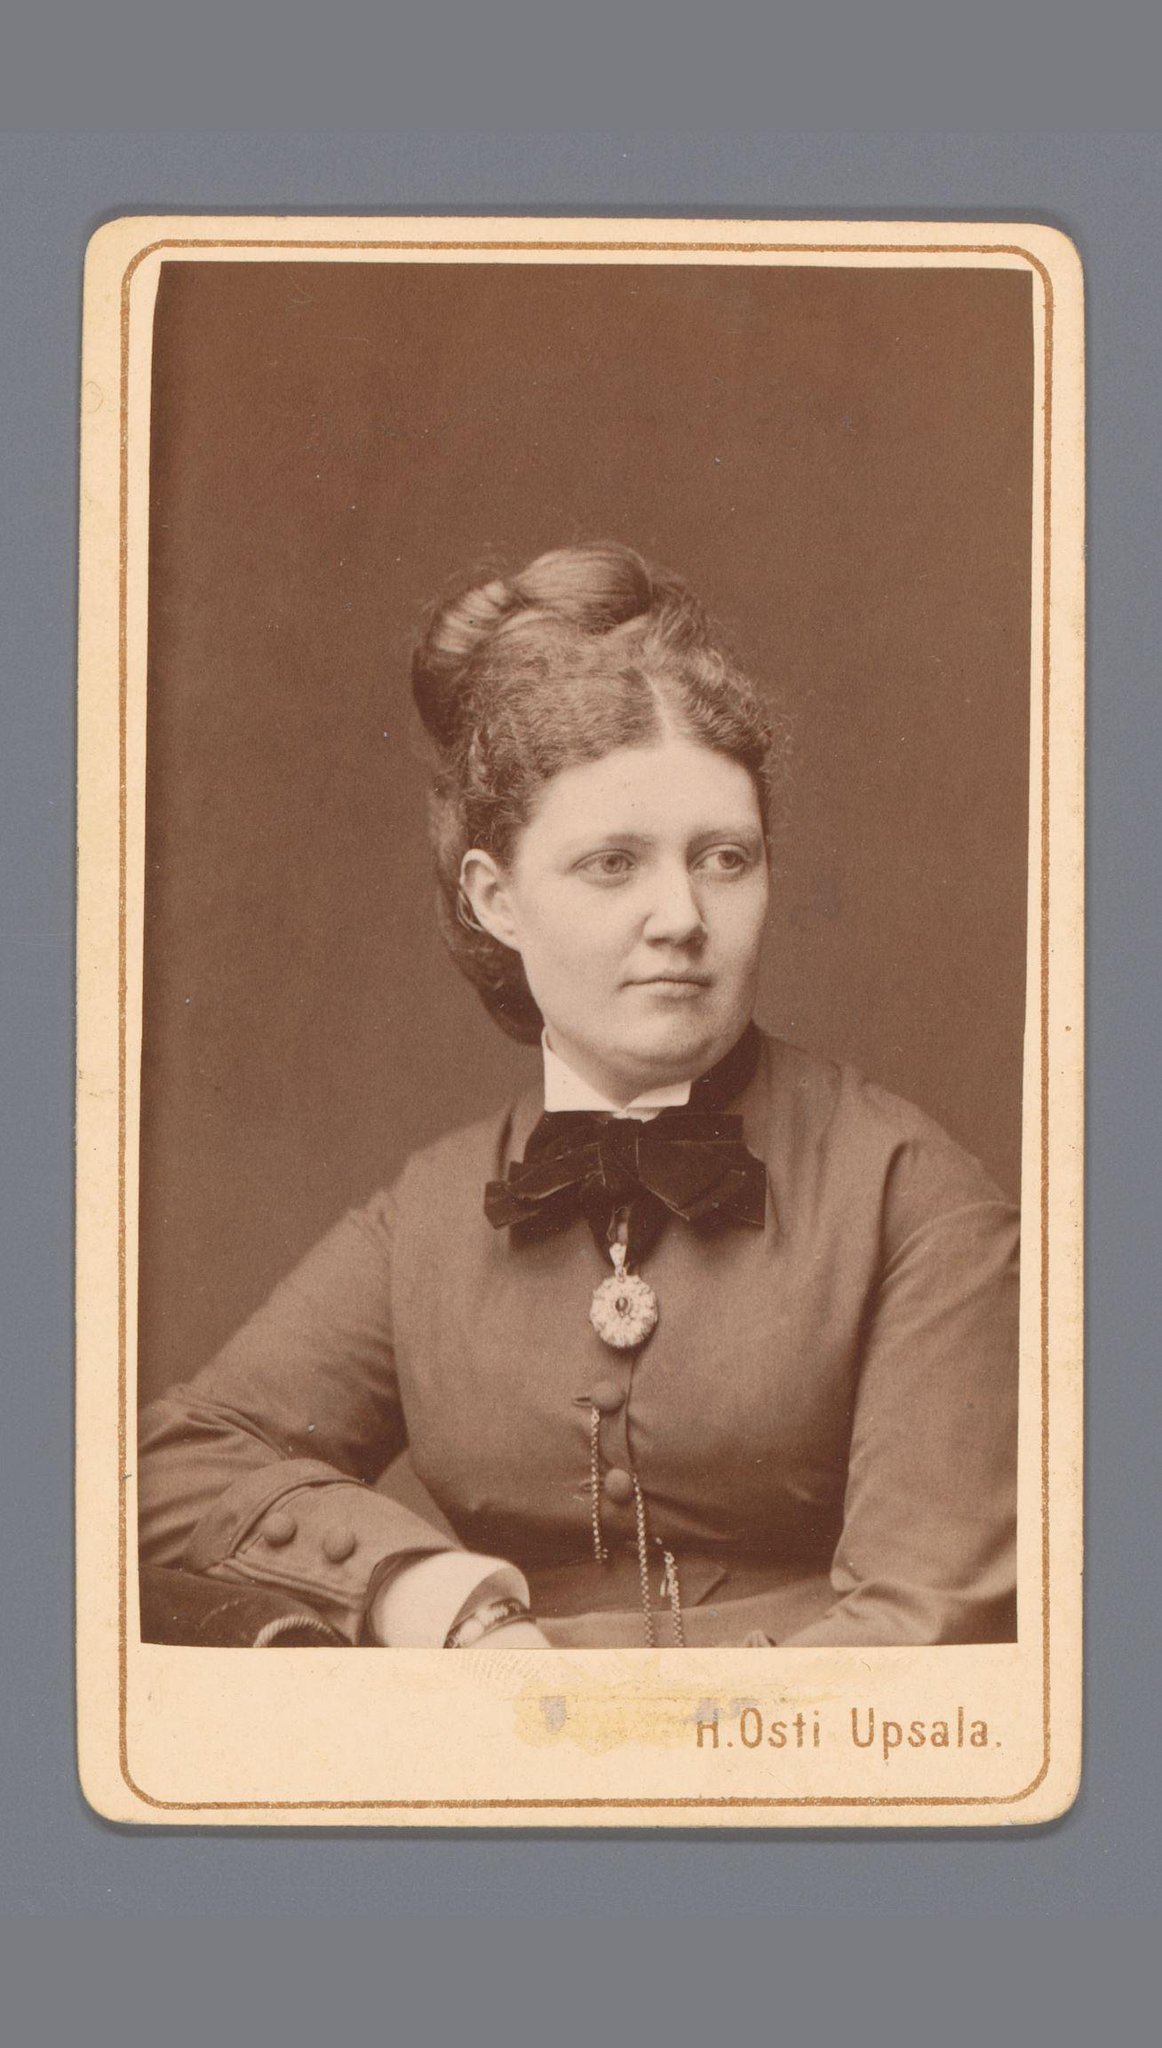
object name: photograph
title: Portret van een onbekende vrouw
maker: henri ostis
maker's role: fotograaf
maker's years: 1826-1914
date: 1860-1875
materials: cardboard, paper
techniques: albumen print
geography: uppsala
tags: adolescent, young woman, maiden, historical persons - bb - woman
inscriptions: inscription: ‘HENRI OSTIS/ FOTOGRAFI ATELIER/ Copiering efter Taflor Fotografier M M./ verkställes i alla storlekar/ UPSALA./ Stora Kungsgatan No. 55./ Plåten förvaras for efterbeställnning’